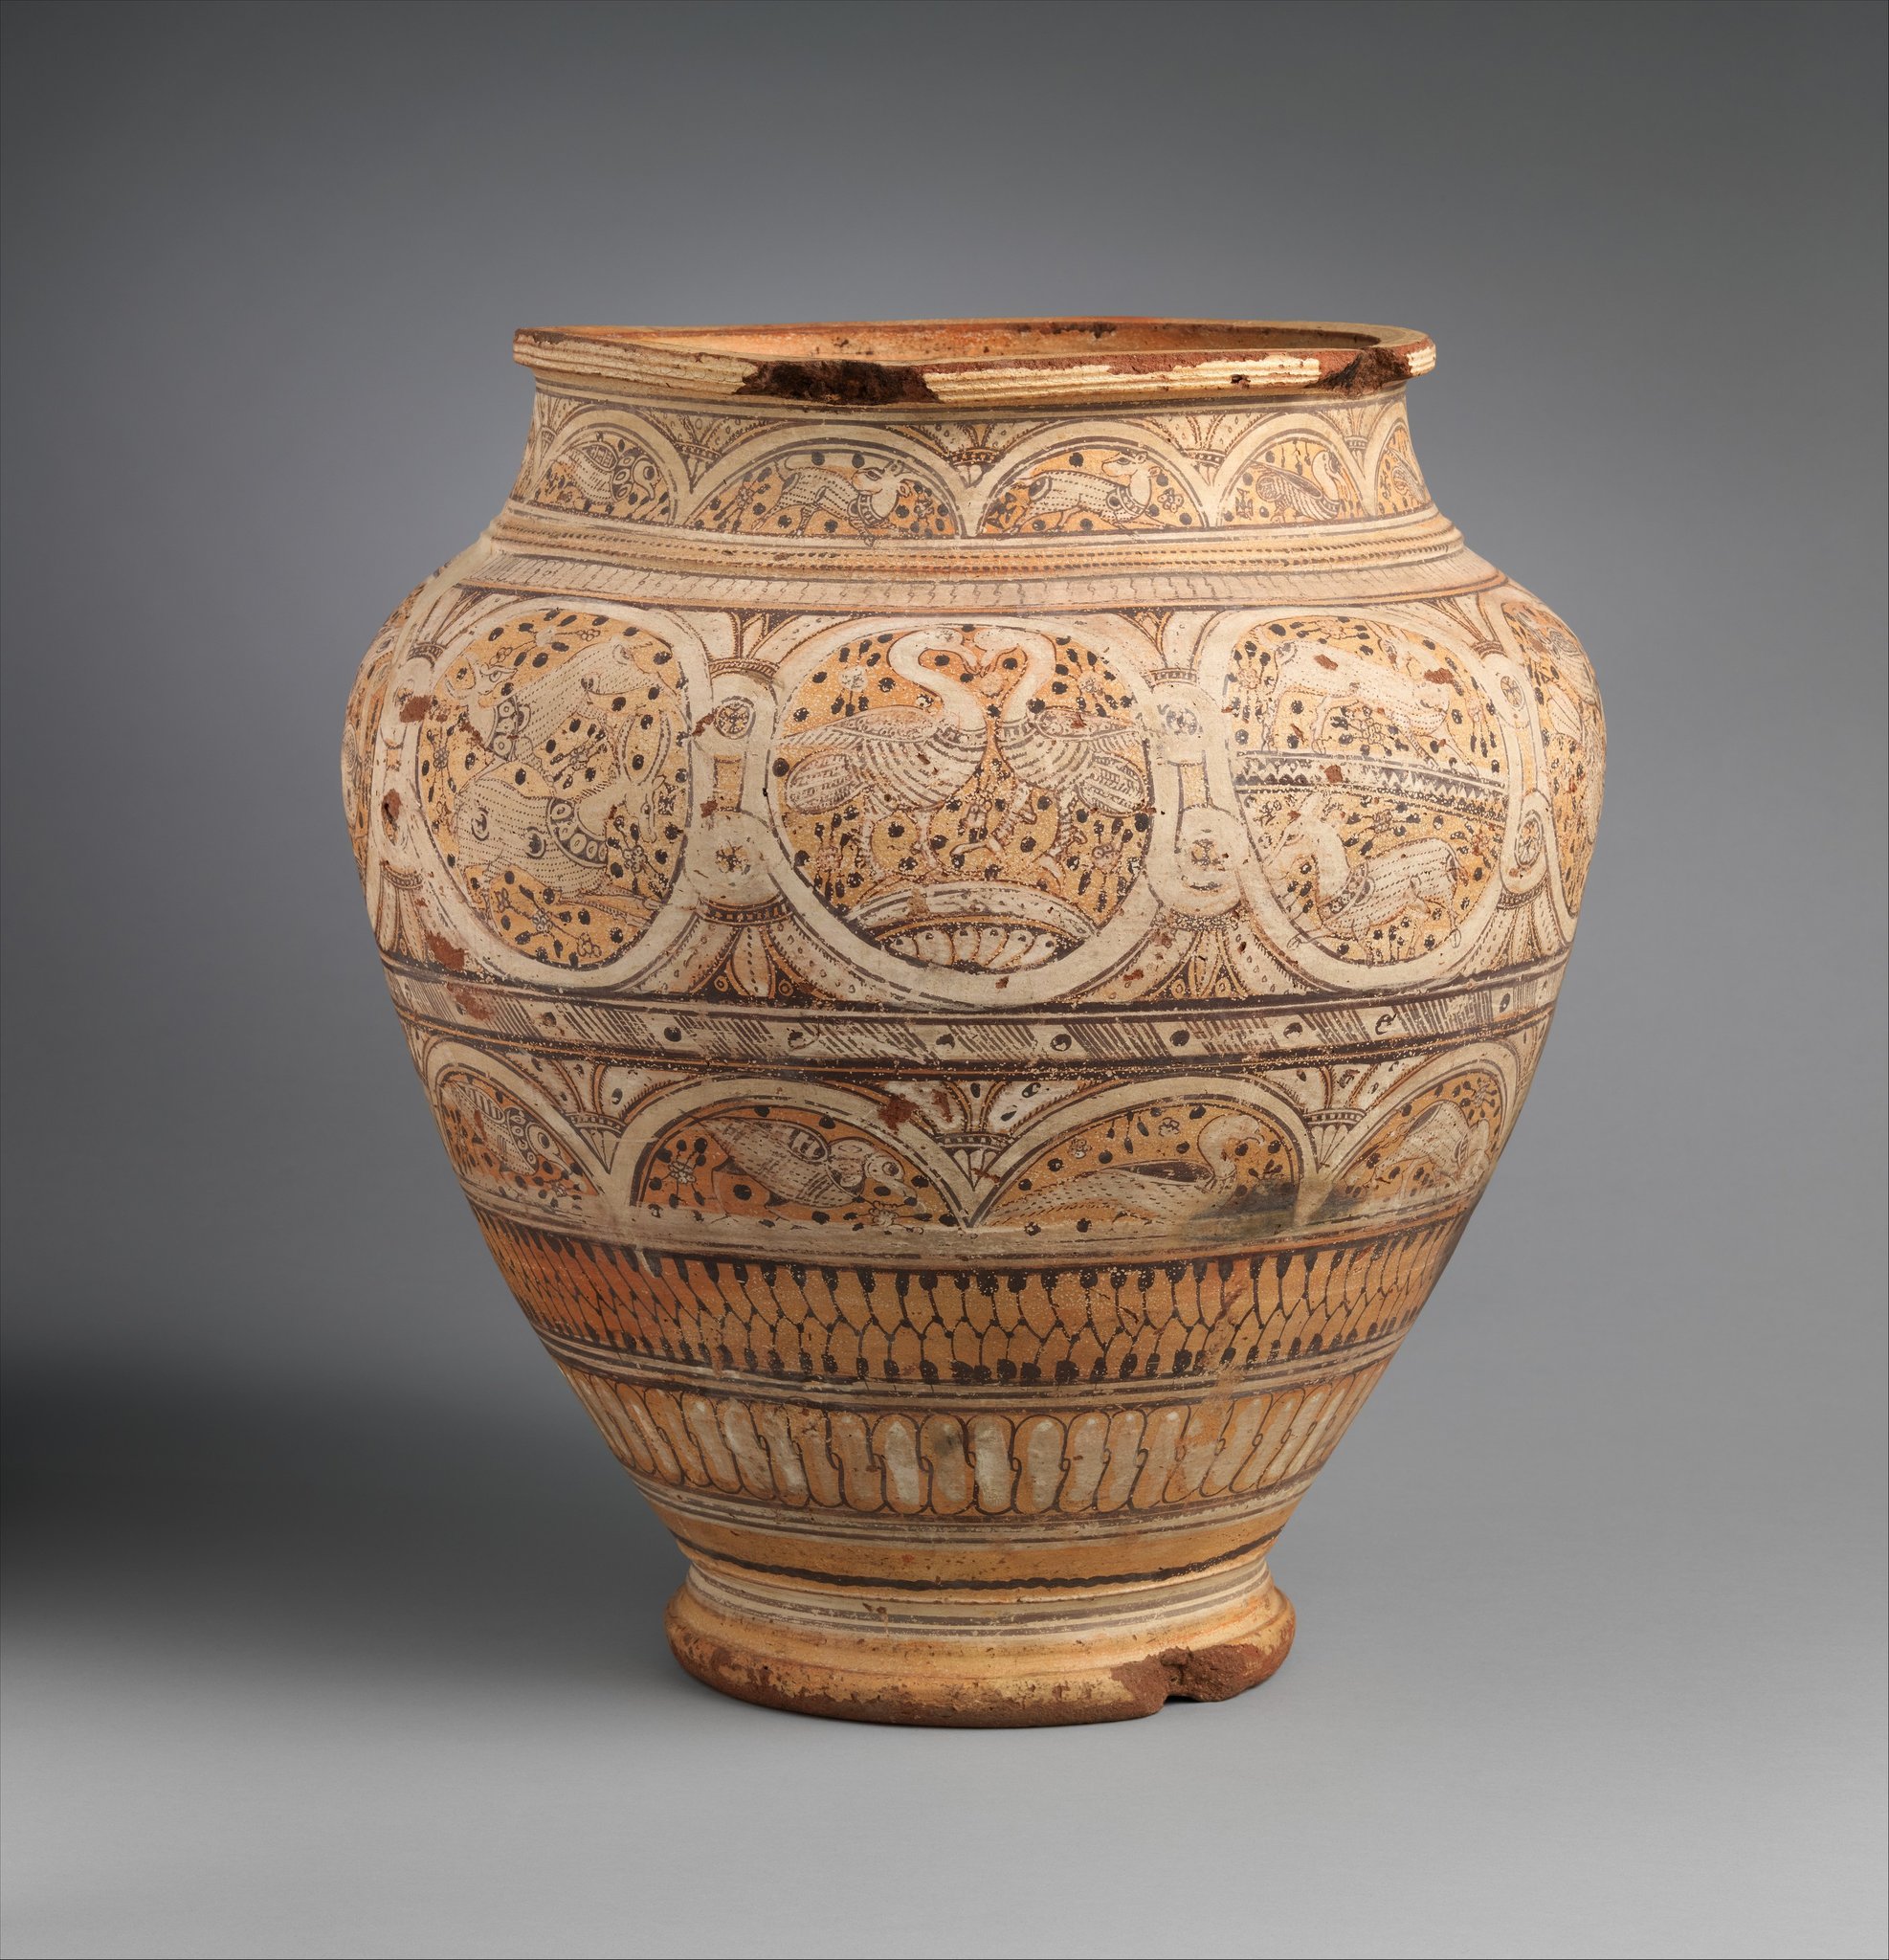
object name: jar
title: Storage Jar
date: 601-700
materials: earthenware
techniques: painting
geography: egypt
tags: animals,birds